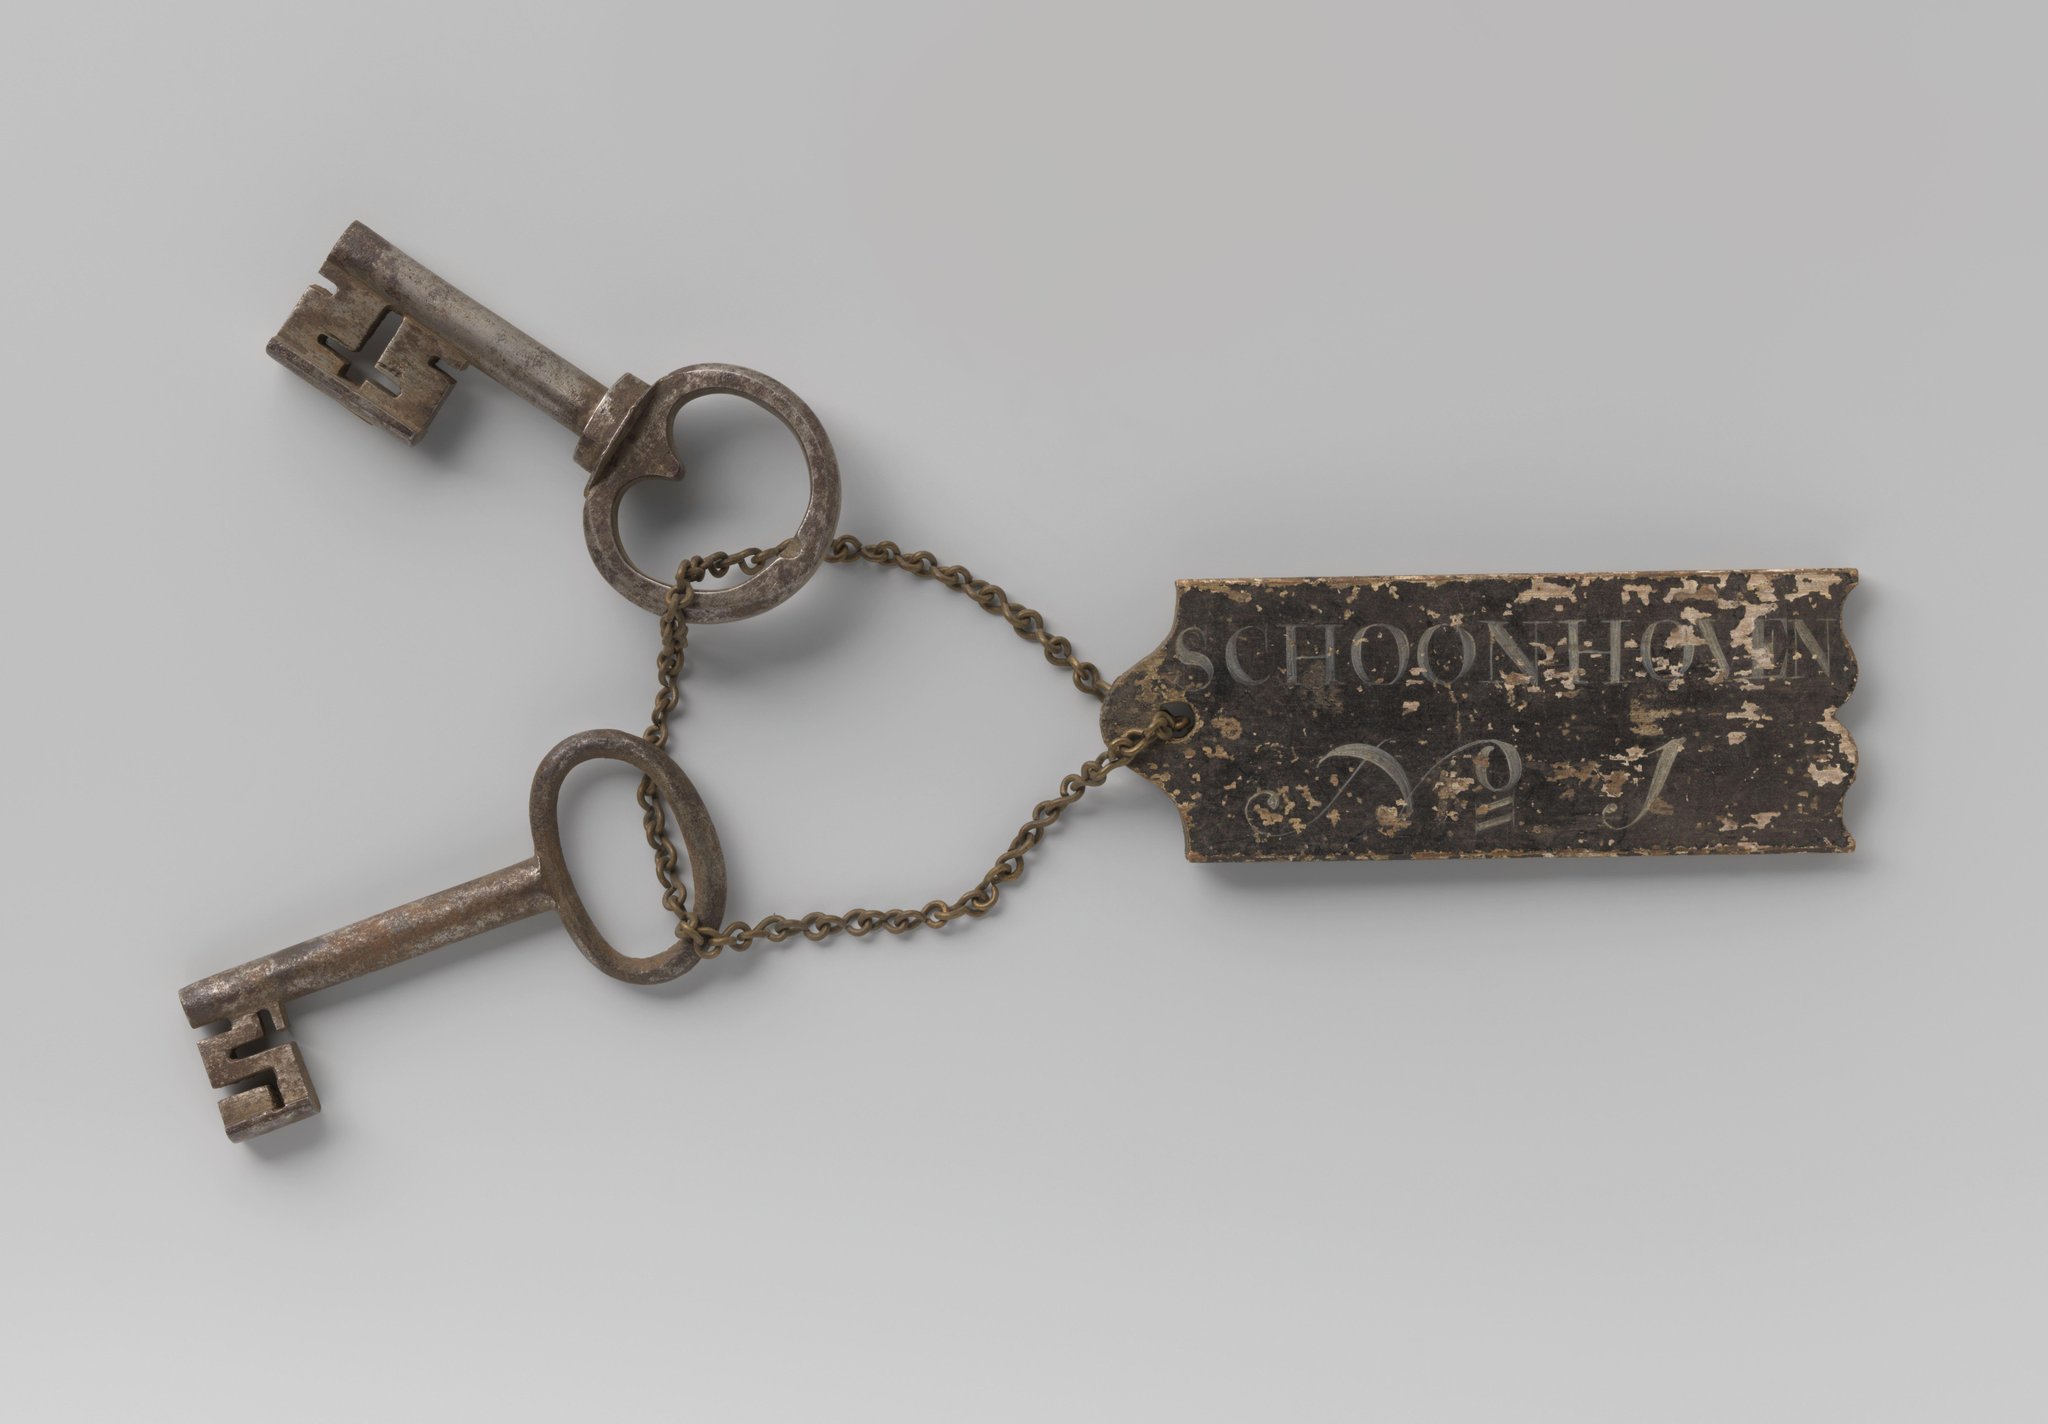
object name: key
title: Sleutels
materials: iron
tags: dordrecht, gouda